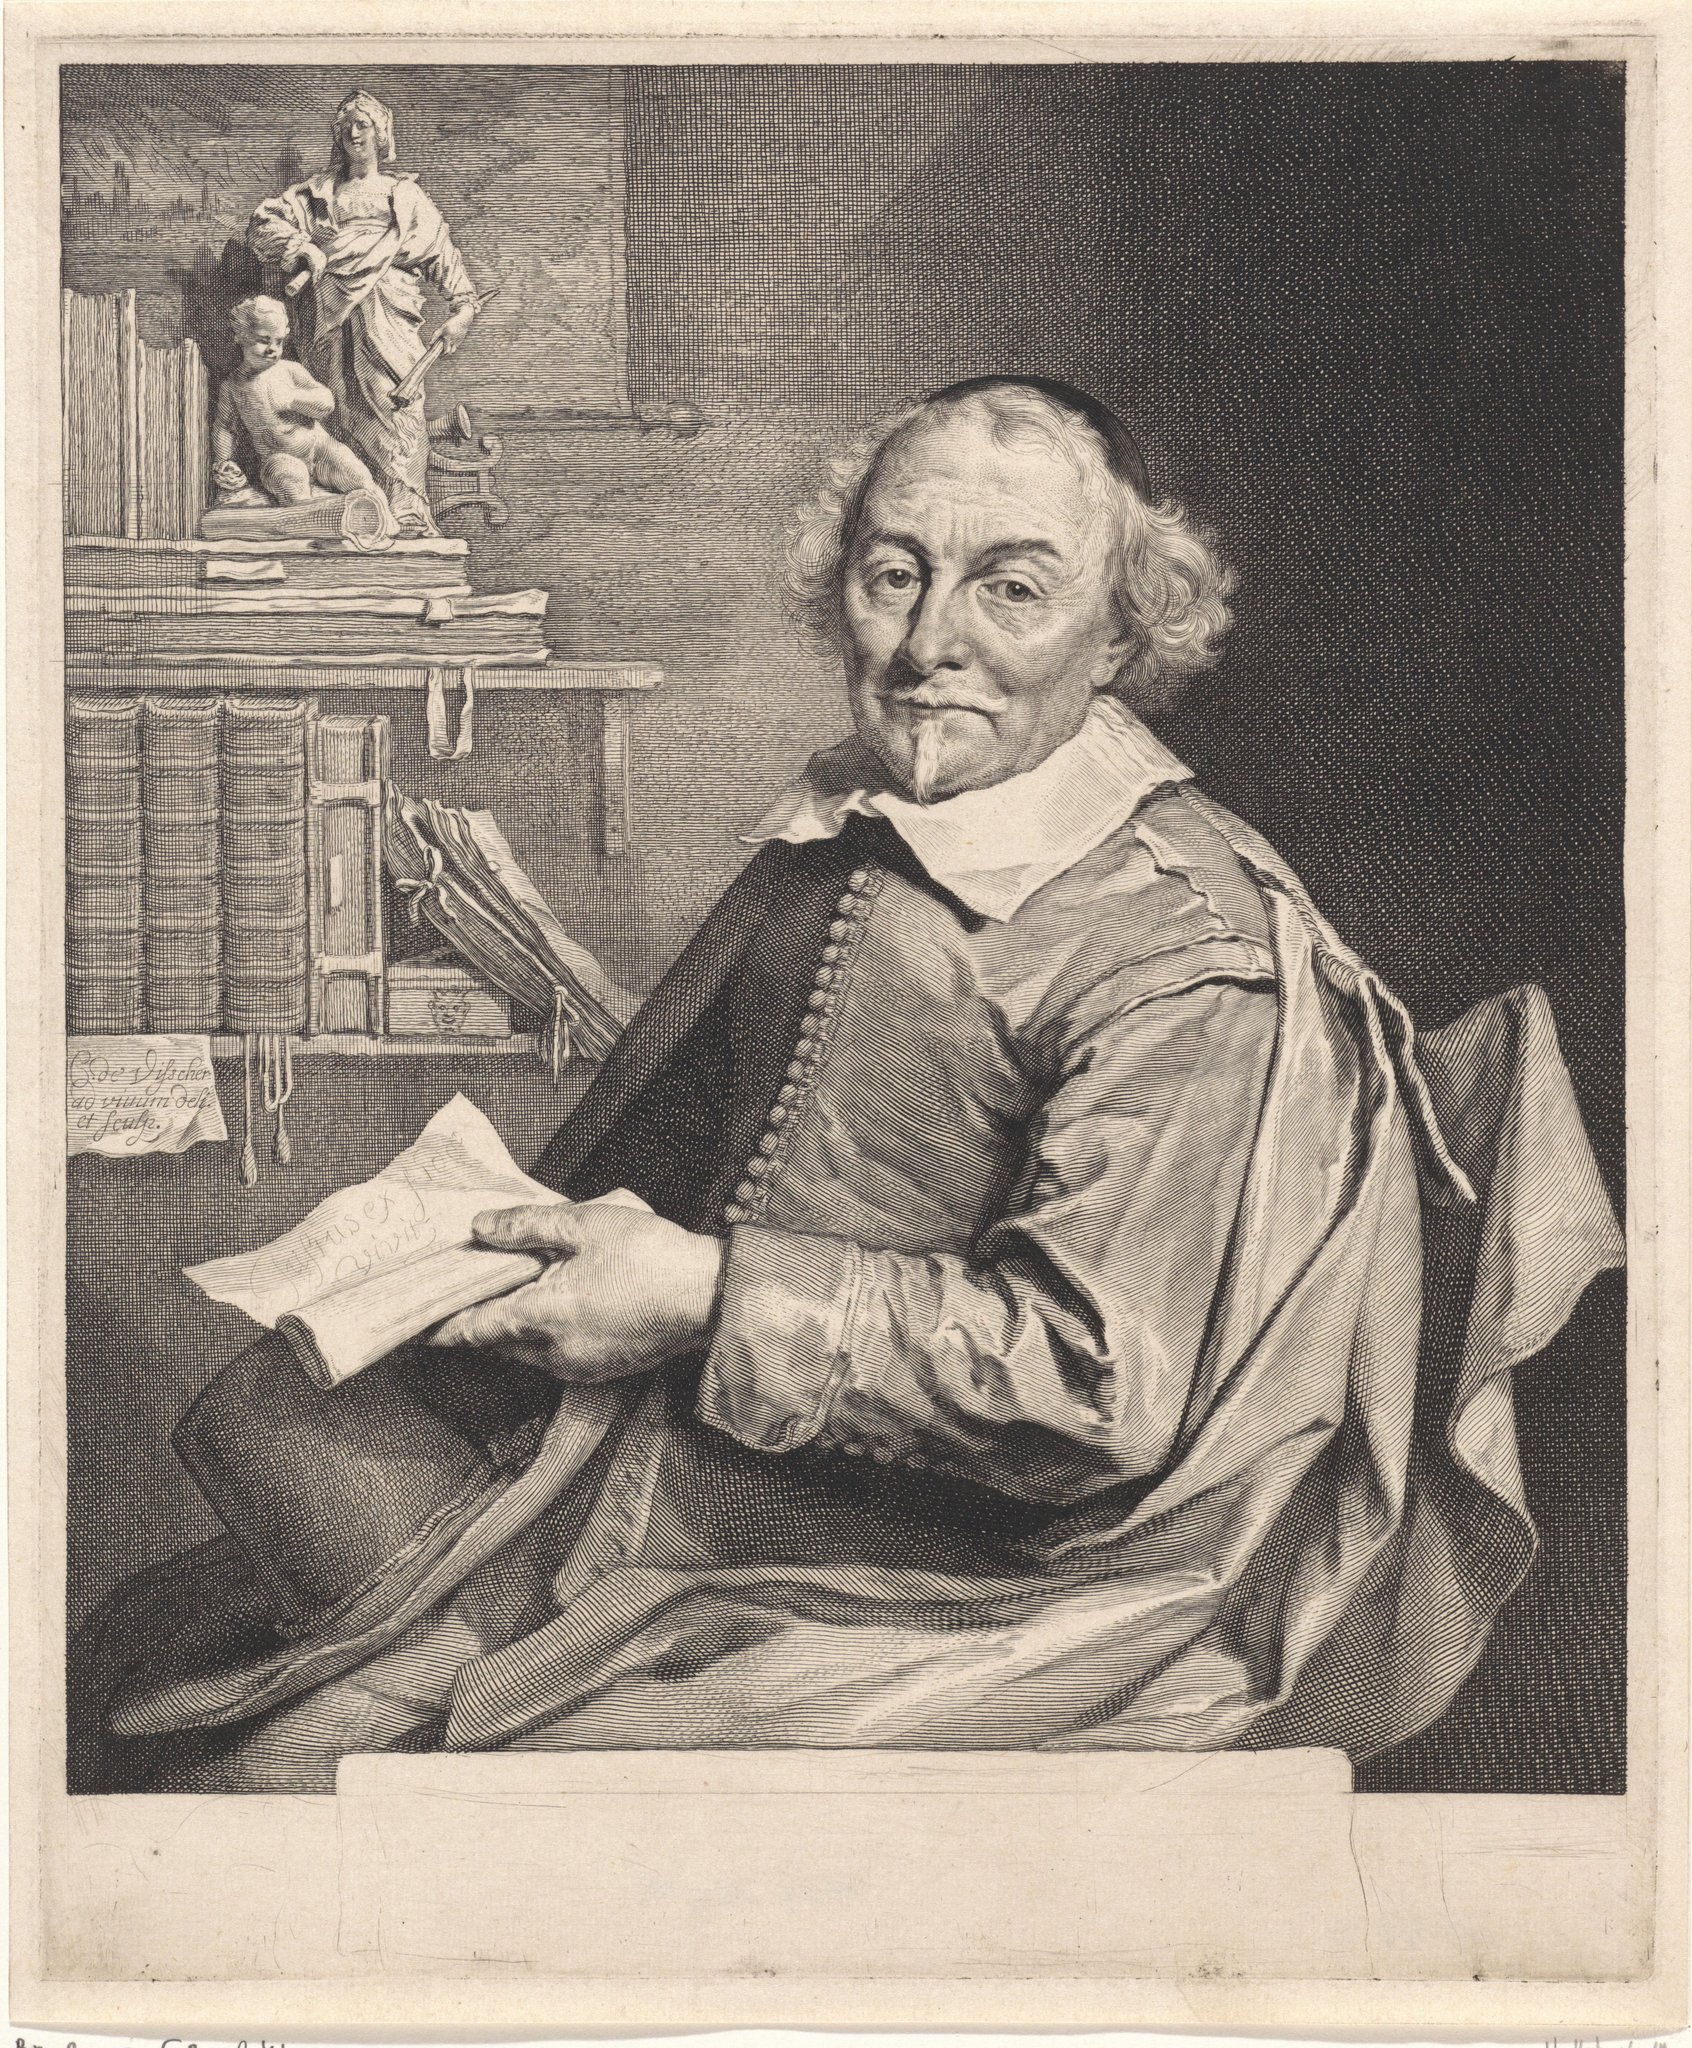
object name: print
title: Portret van Joost van den Vondel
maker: cornelis visscher (ii)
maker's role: draughtsman, painter, print maker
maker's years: 1628-1658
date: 1657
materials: paper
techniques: engraving, etching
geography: haarlem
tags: cologne, amsterdam, joost van den vondel, print, e.g.: engraving, etching, lithograph, head-gear: hat (+ men's clothes), sculpture, cupids: 'amores', 'amoretti', 'putti'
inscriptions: collector's mark: Lugt 240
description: De schrijver en dichter Joost van den Vondel op 70-jarige leeftijd in zijn werkkamer. Hij draagt een kalot en heeft een beschreven rol papier in zijn hand. Hij zit bij twee planken met boeken en beelden van een vrouw en een putto. Aan de muur hangt een op stokken geslagen prent.